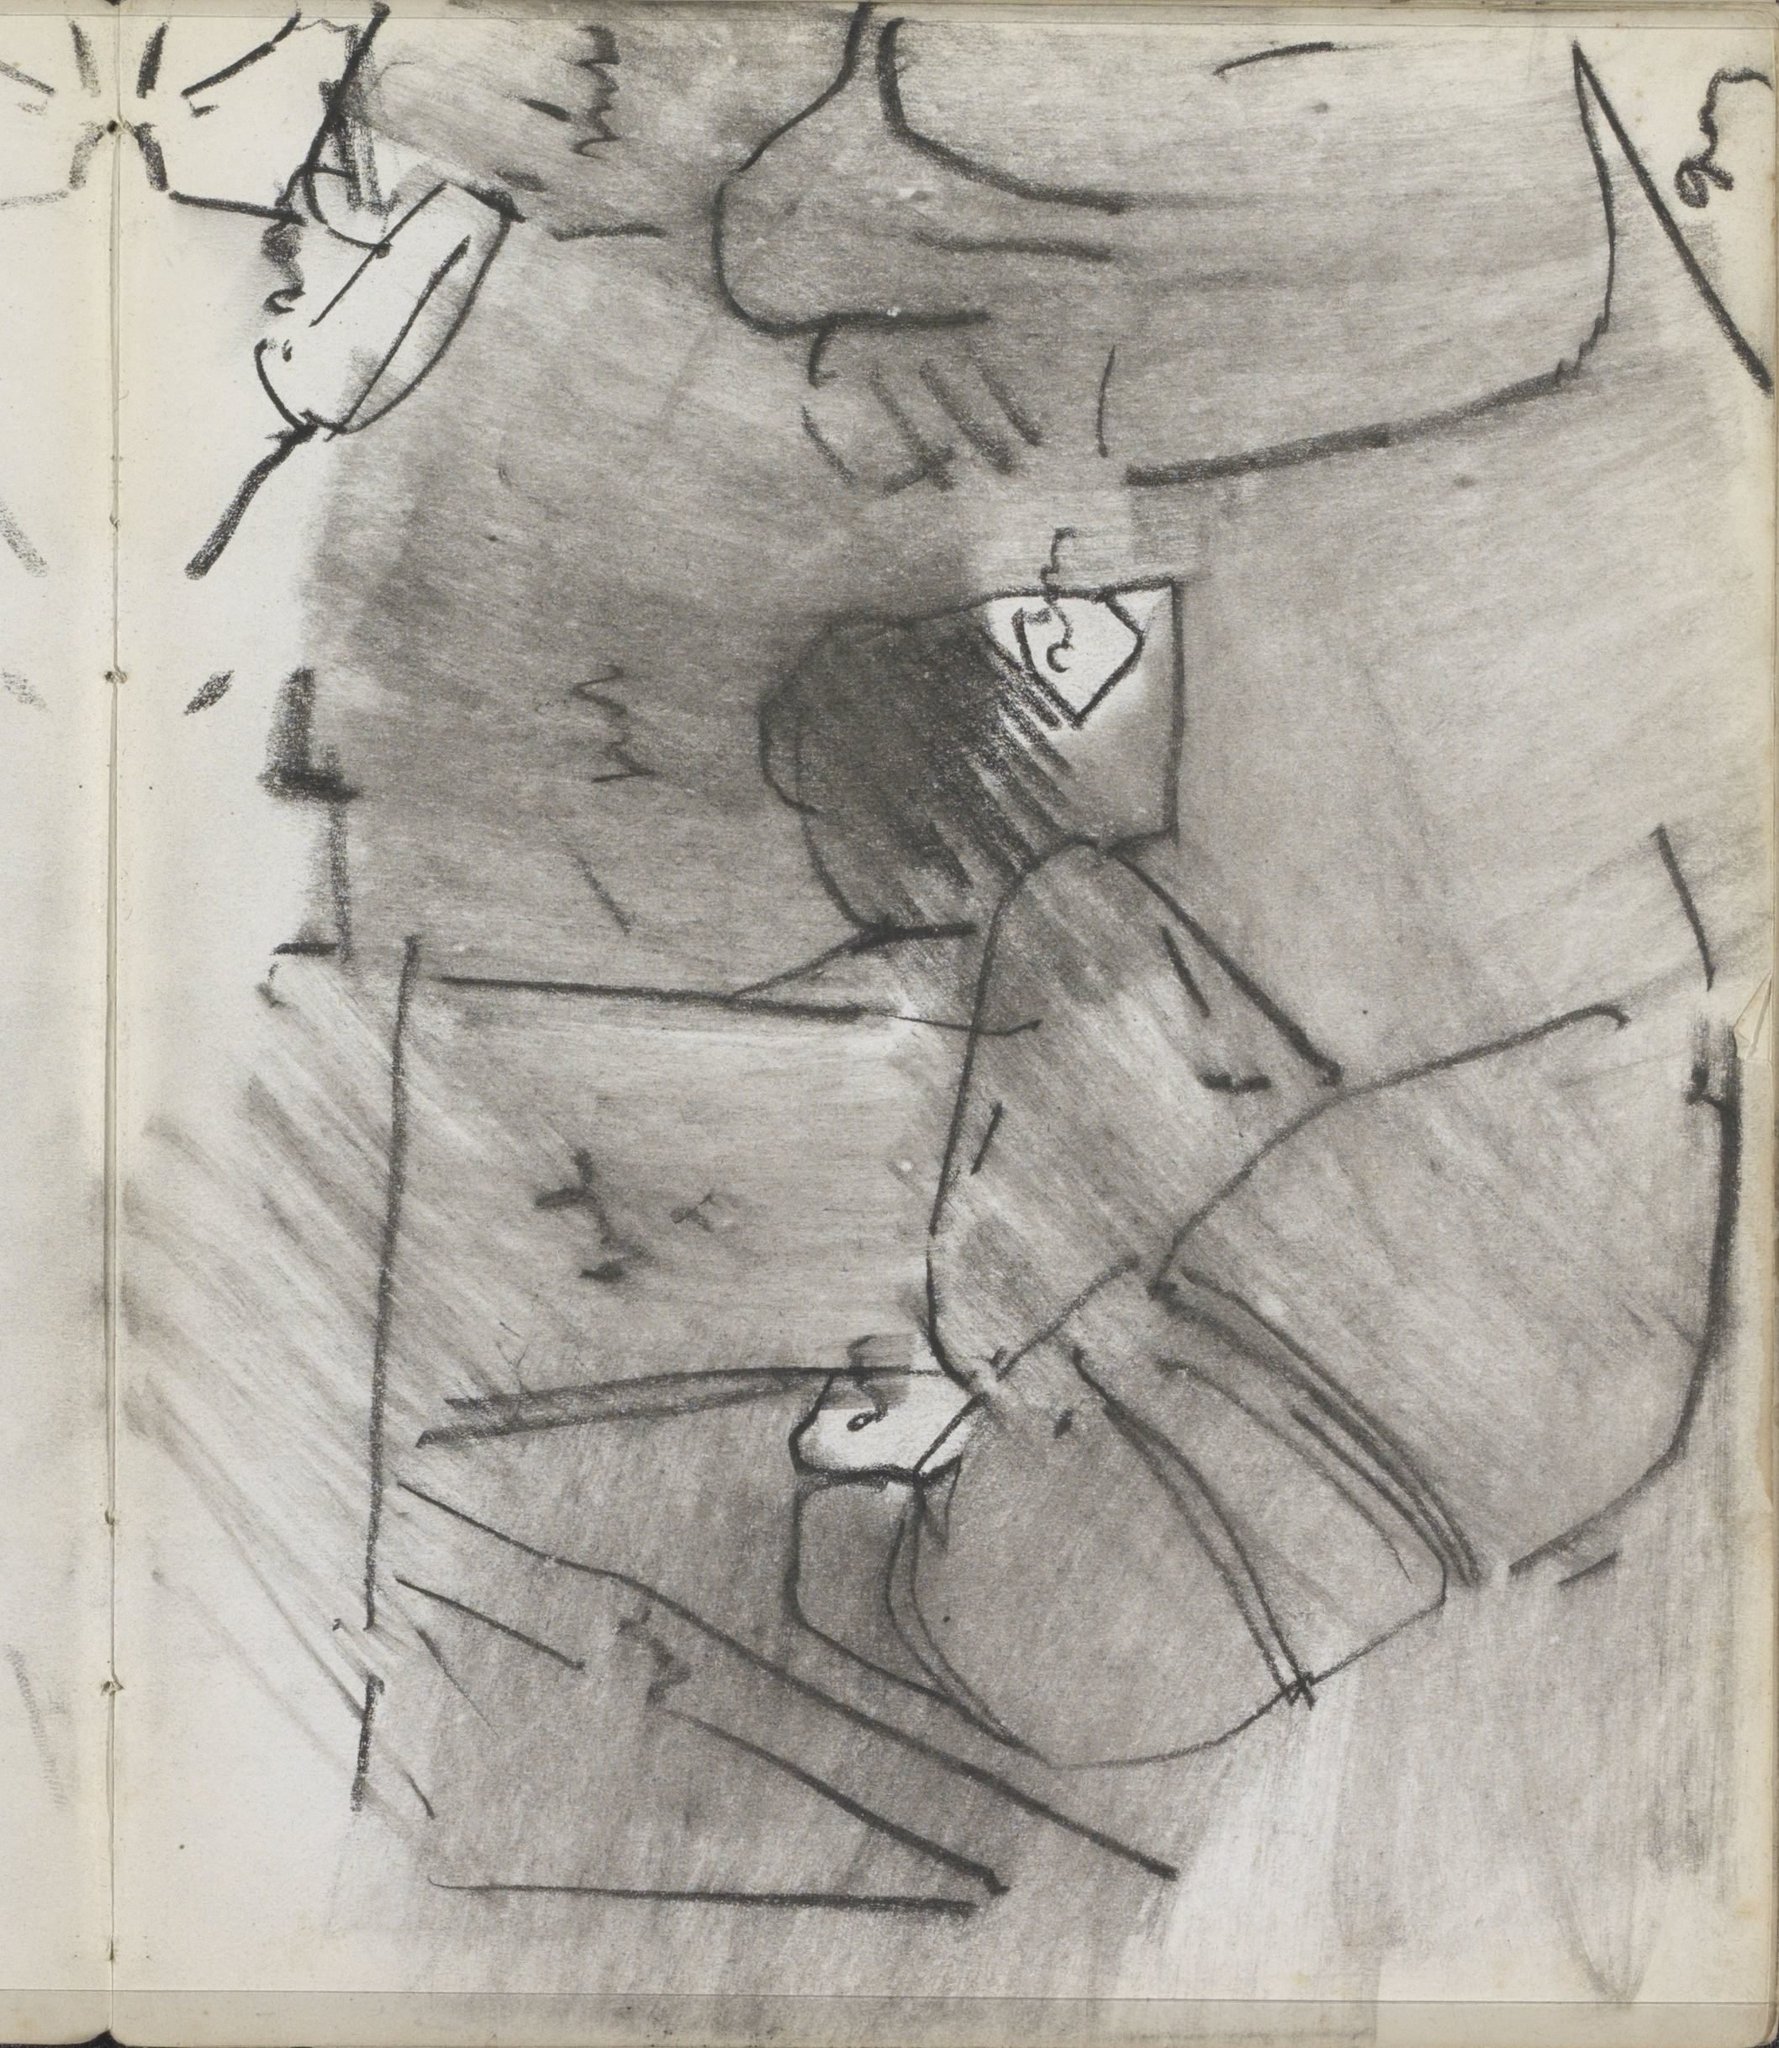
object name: sketchbook leaf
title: Studie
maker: george hendrik breitner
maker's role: draughtsman, painter, print maker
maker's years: 1857-1923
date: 1880-1906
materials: chalk, paper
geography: netherlands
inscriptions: kleurnotitie, handgeschreven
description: Pagina 8 uit een schetsboek met 81 bladen.